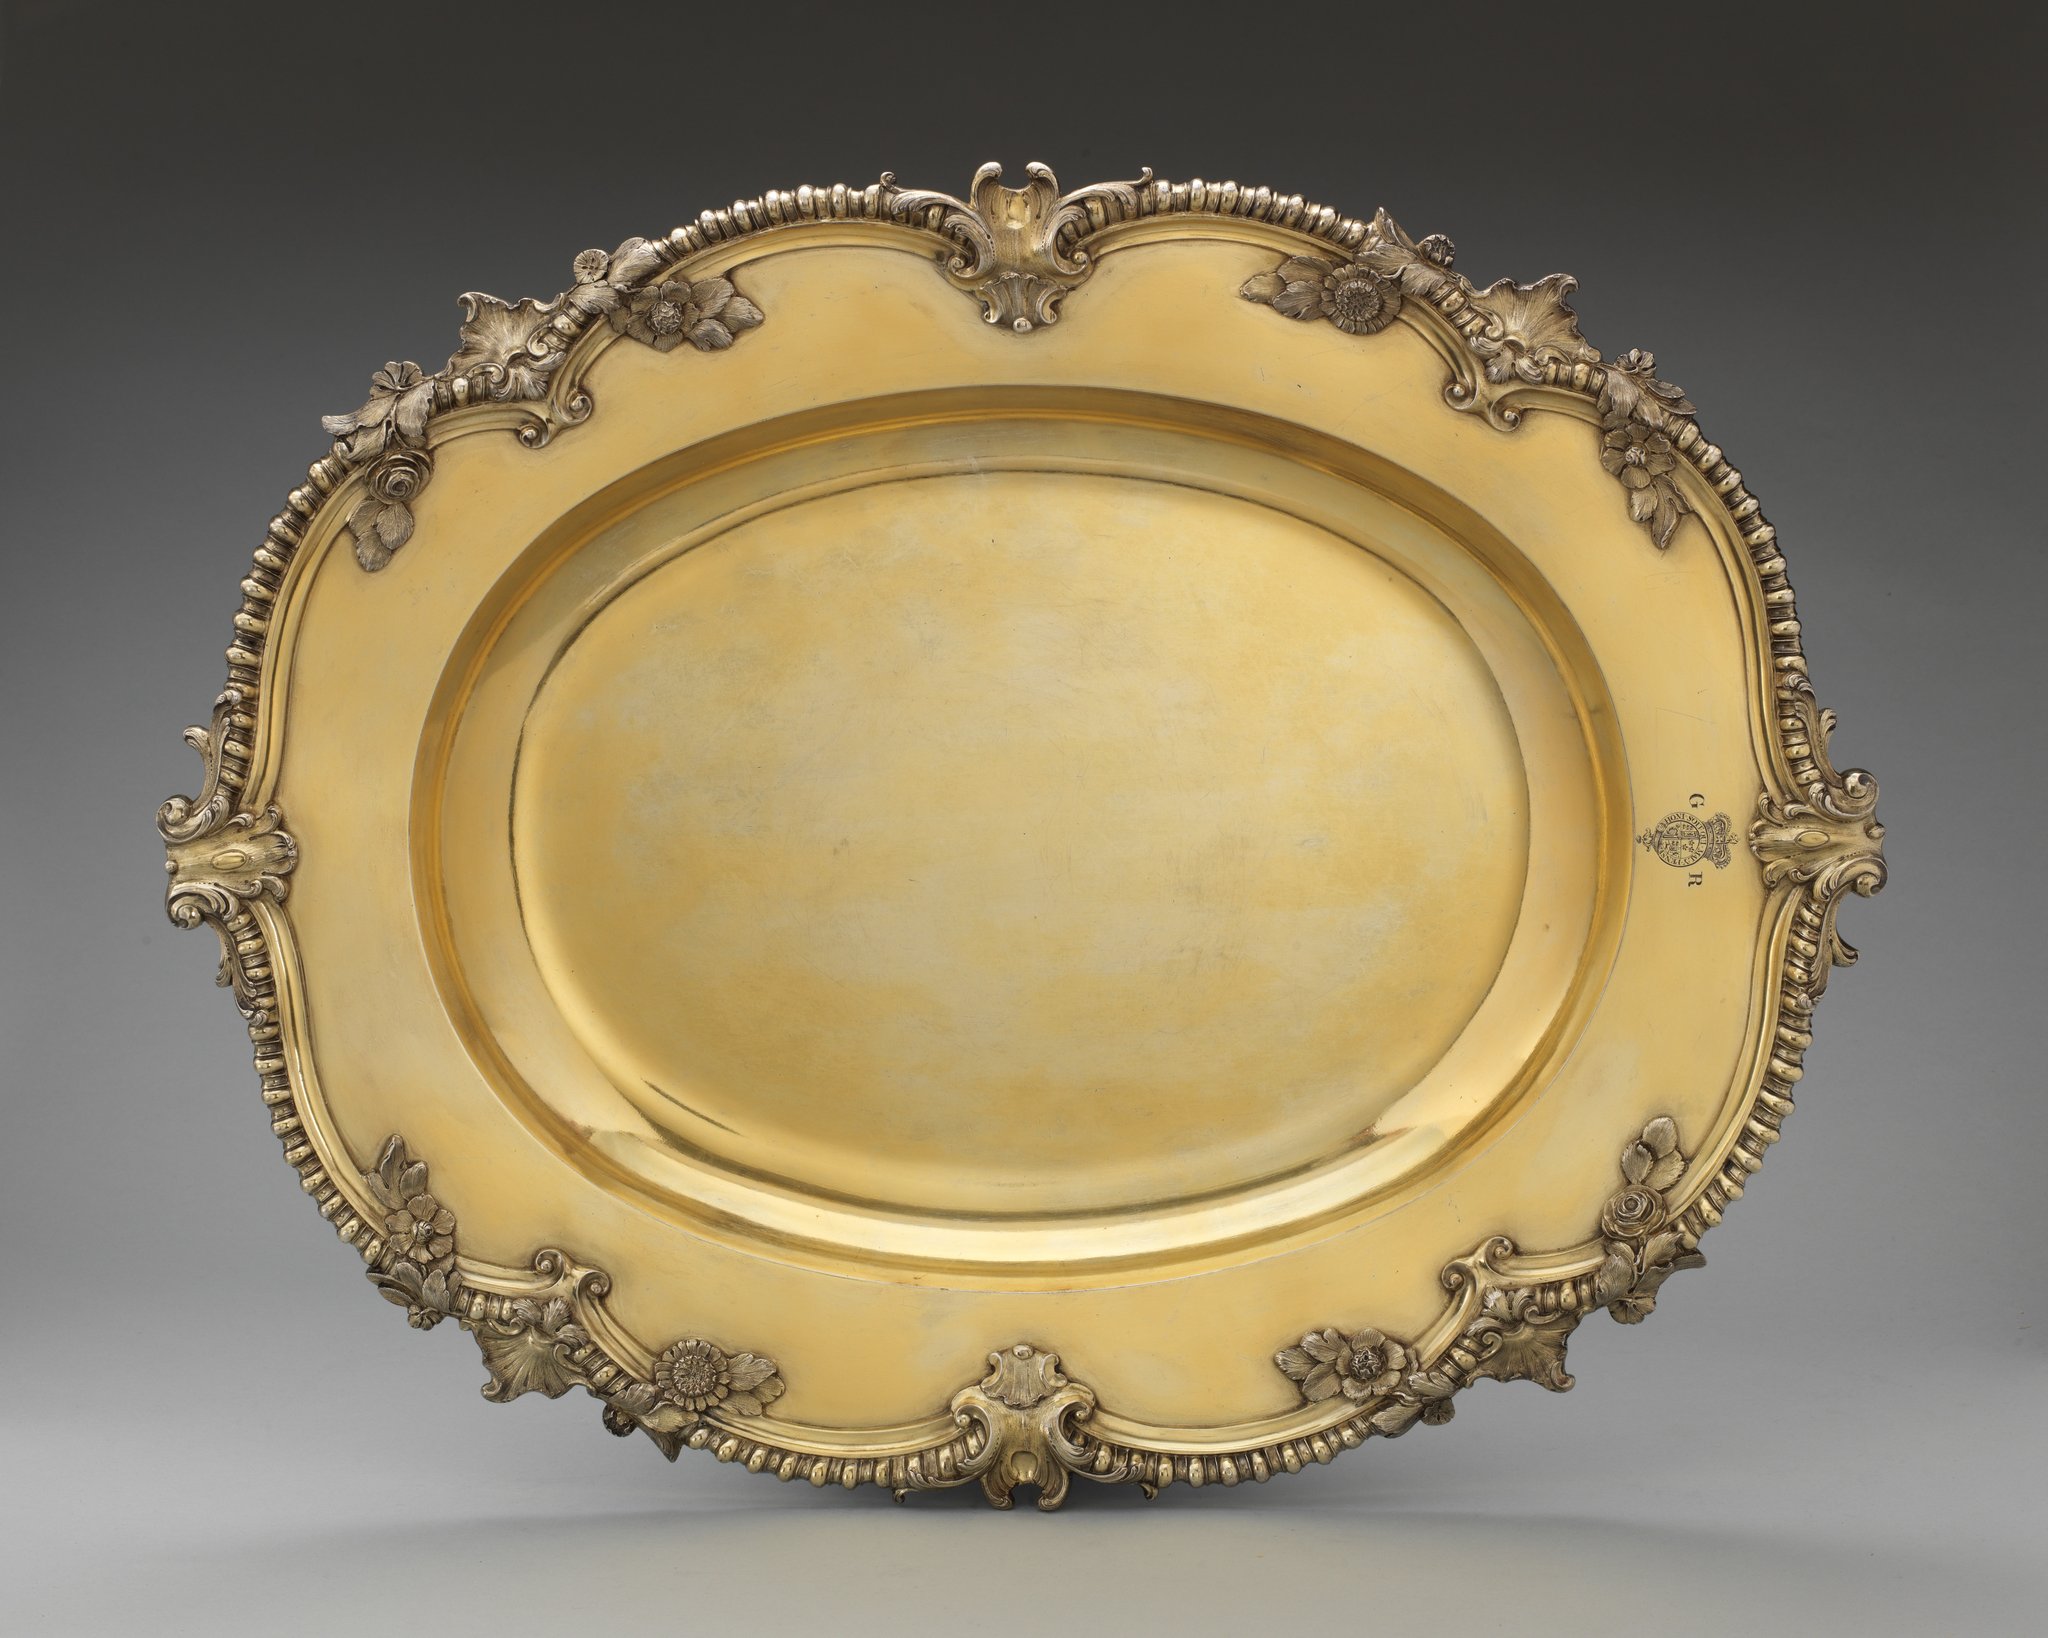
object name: basin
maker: abraham portal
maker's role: maker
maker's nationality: british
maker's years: 1709-1809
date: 1755-1756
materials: silver gilt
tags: flowers,coat of arms